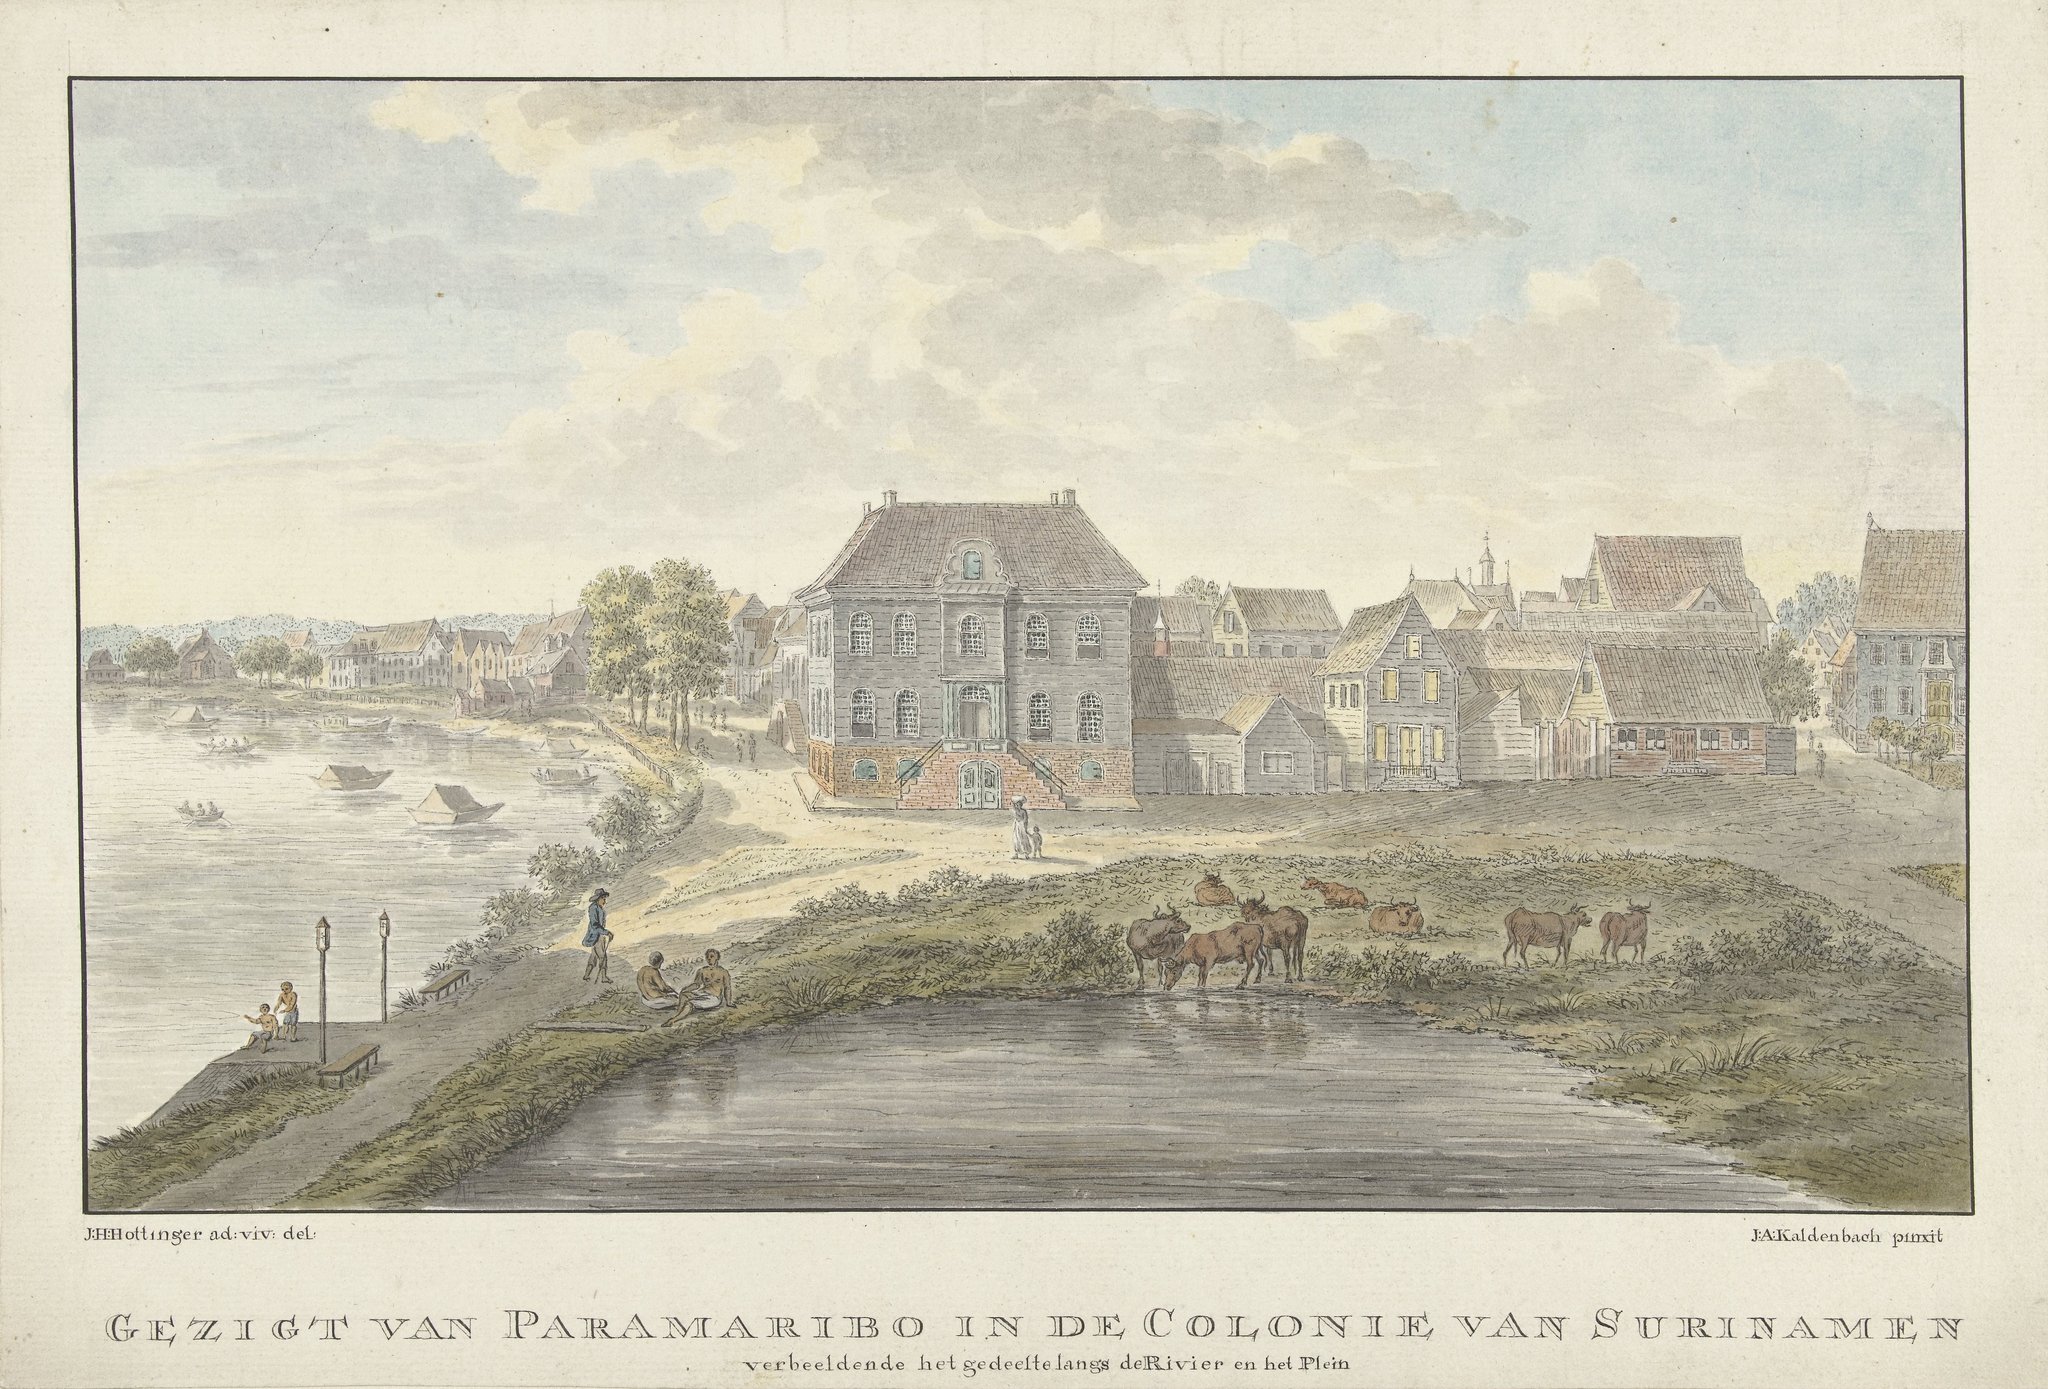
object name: drawing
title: Gezicht op Paramaribo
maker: johan antonie kaldenbach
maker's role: draughtsman, print maker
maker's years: 1760-1818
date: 1770-1818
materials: ink, paper, pencil, watercolor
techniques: brush, pen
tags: prospect of city, town panorama, silhouette of city